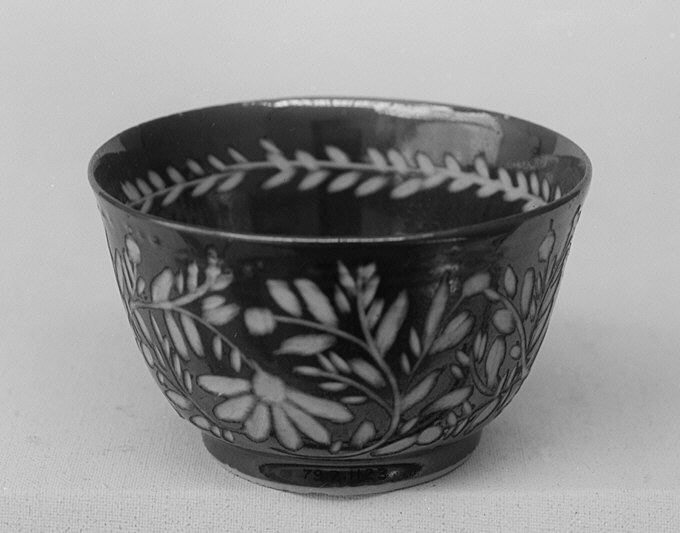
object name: teabowl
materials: hard paste porcelain